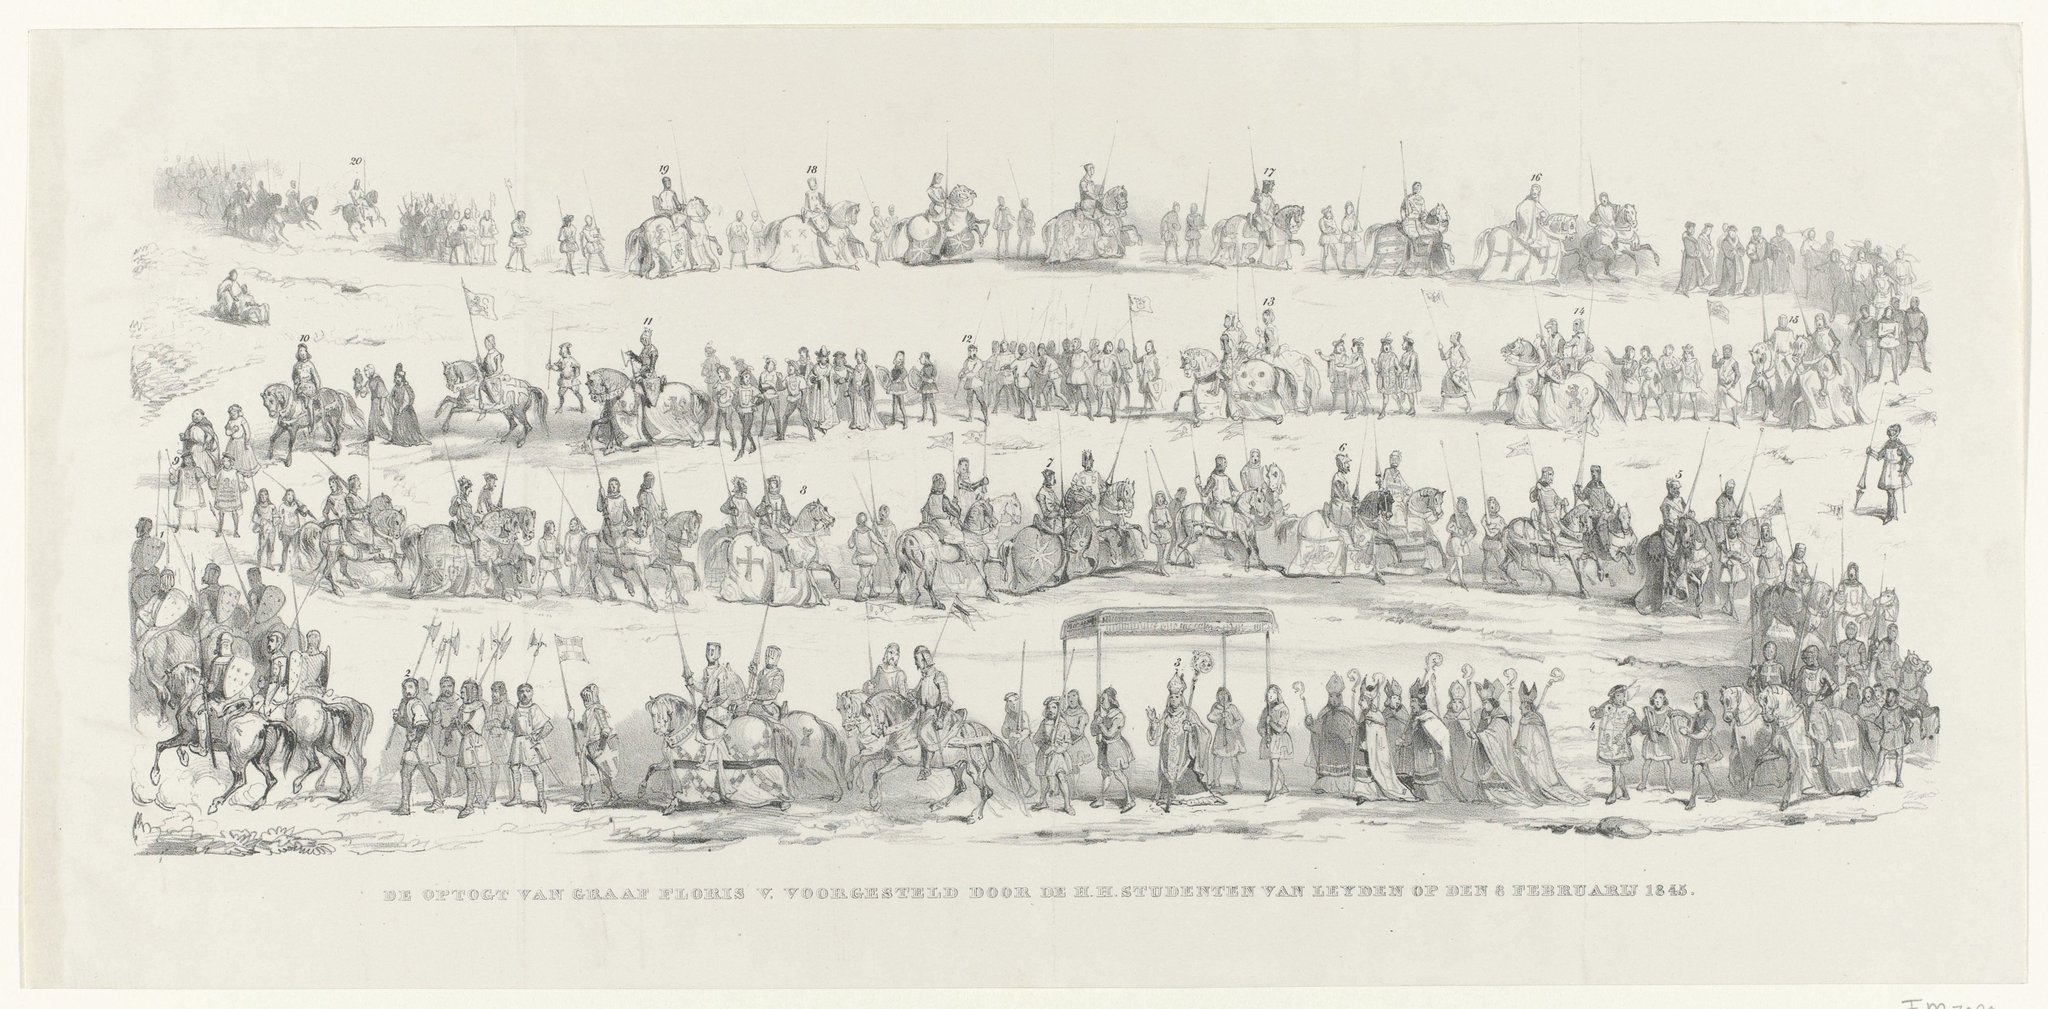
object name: print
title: De Optogt van Graaf Floris V. voorgesteld door de H.H. Studenten van Leyden op den 8 Februarij 1845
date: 1845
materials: paper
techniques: lithograph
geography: dordrecht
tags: floris v (graaf van holland en zeeland), students' pageant, costumes used in pageants, leiden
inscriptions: collector's mark: Lugt 2228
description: Gekostumeerde historische optocht met graaf Floris V met de pas geslagen St. Jacobs-ridders, naar het door hem bij de instelling van die orde gegeven toernooi te Den Haag in het jaar 1279. Door de studenten van het Leidsch Studenten Corps op 8 februari 1845 ter gelegenheid van de 270ste verjaardag van de Leidsche Hogeschool. De stoet afgebeeld in vier rijen boven elkaar, onderdelen genummerd 1-20.